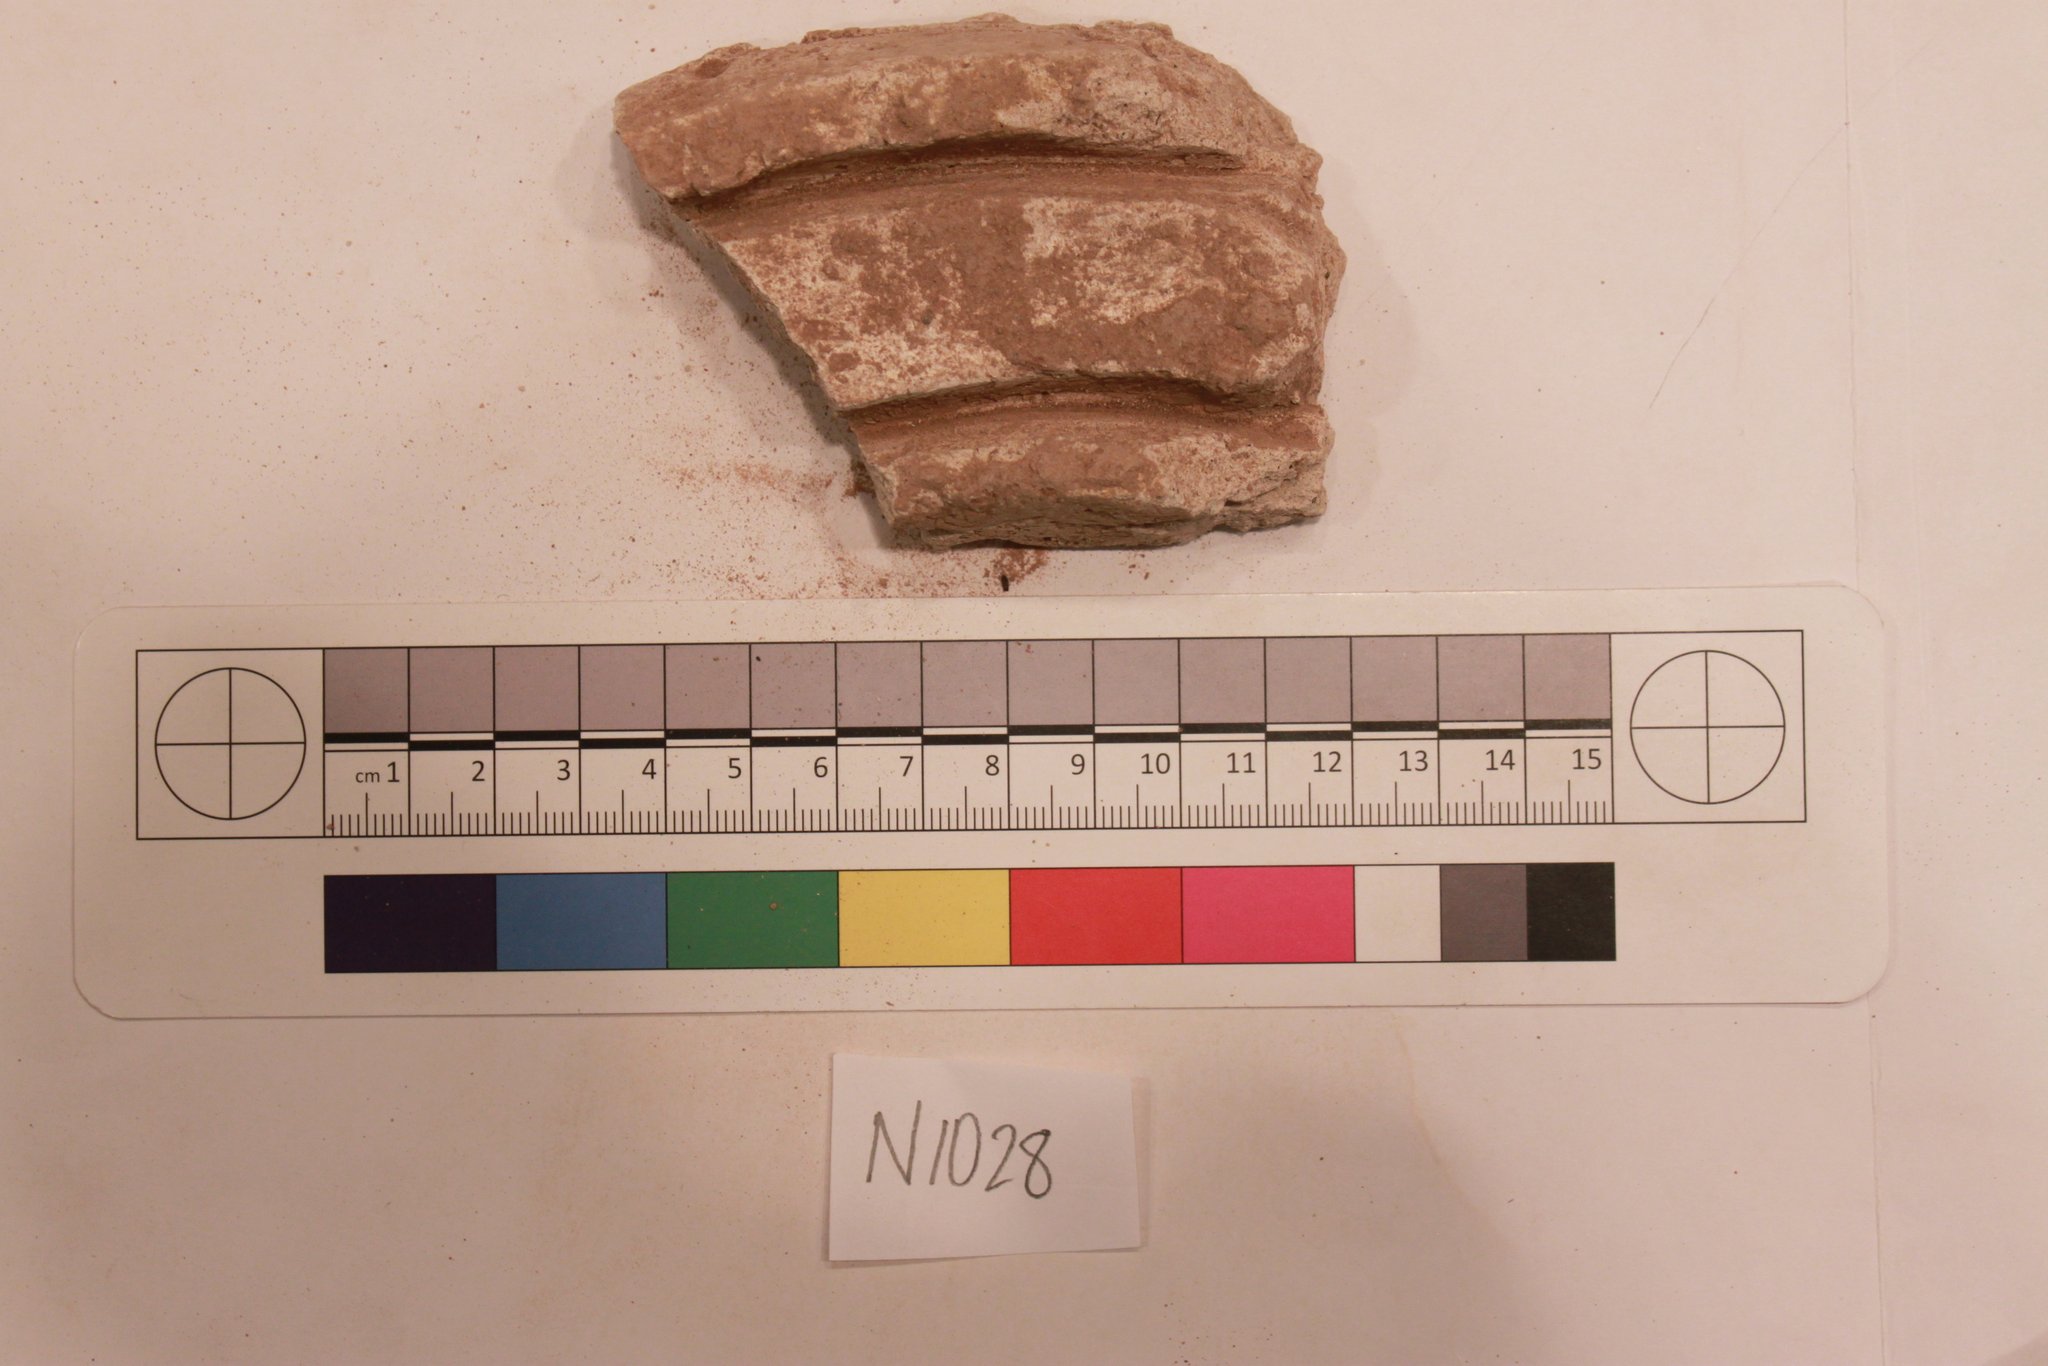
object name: fragment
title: Stucco Fragment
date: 701-1200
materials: plaster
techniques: carving, painting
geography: iran